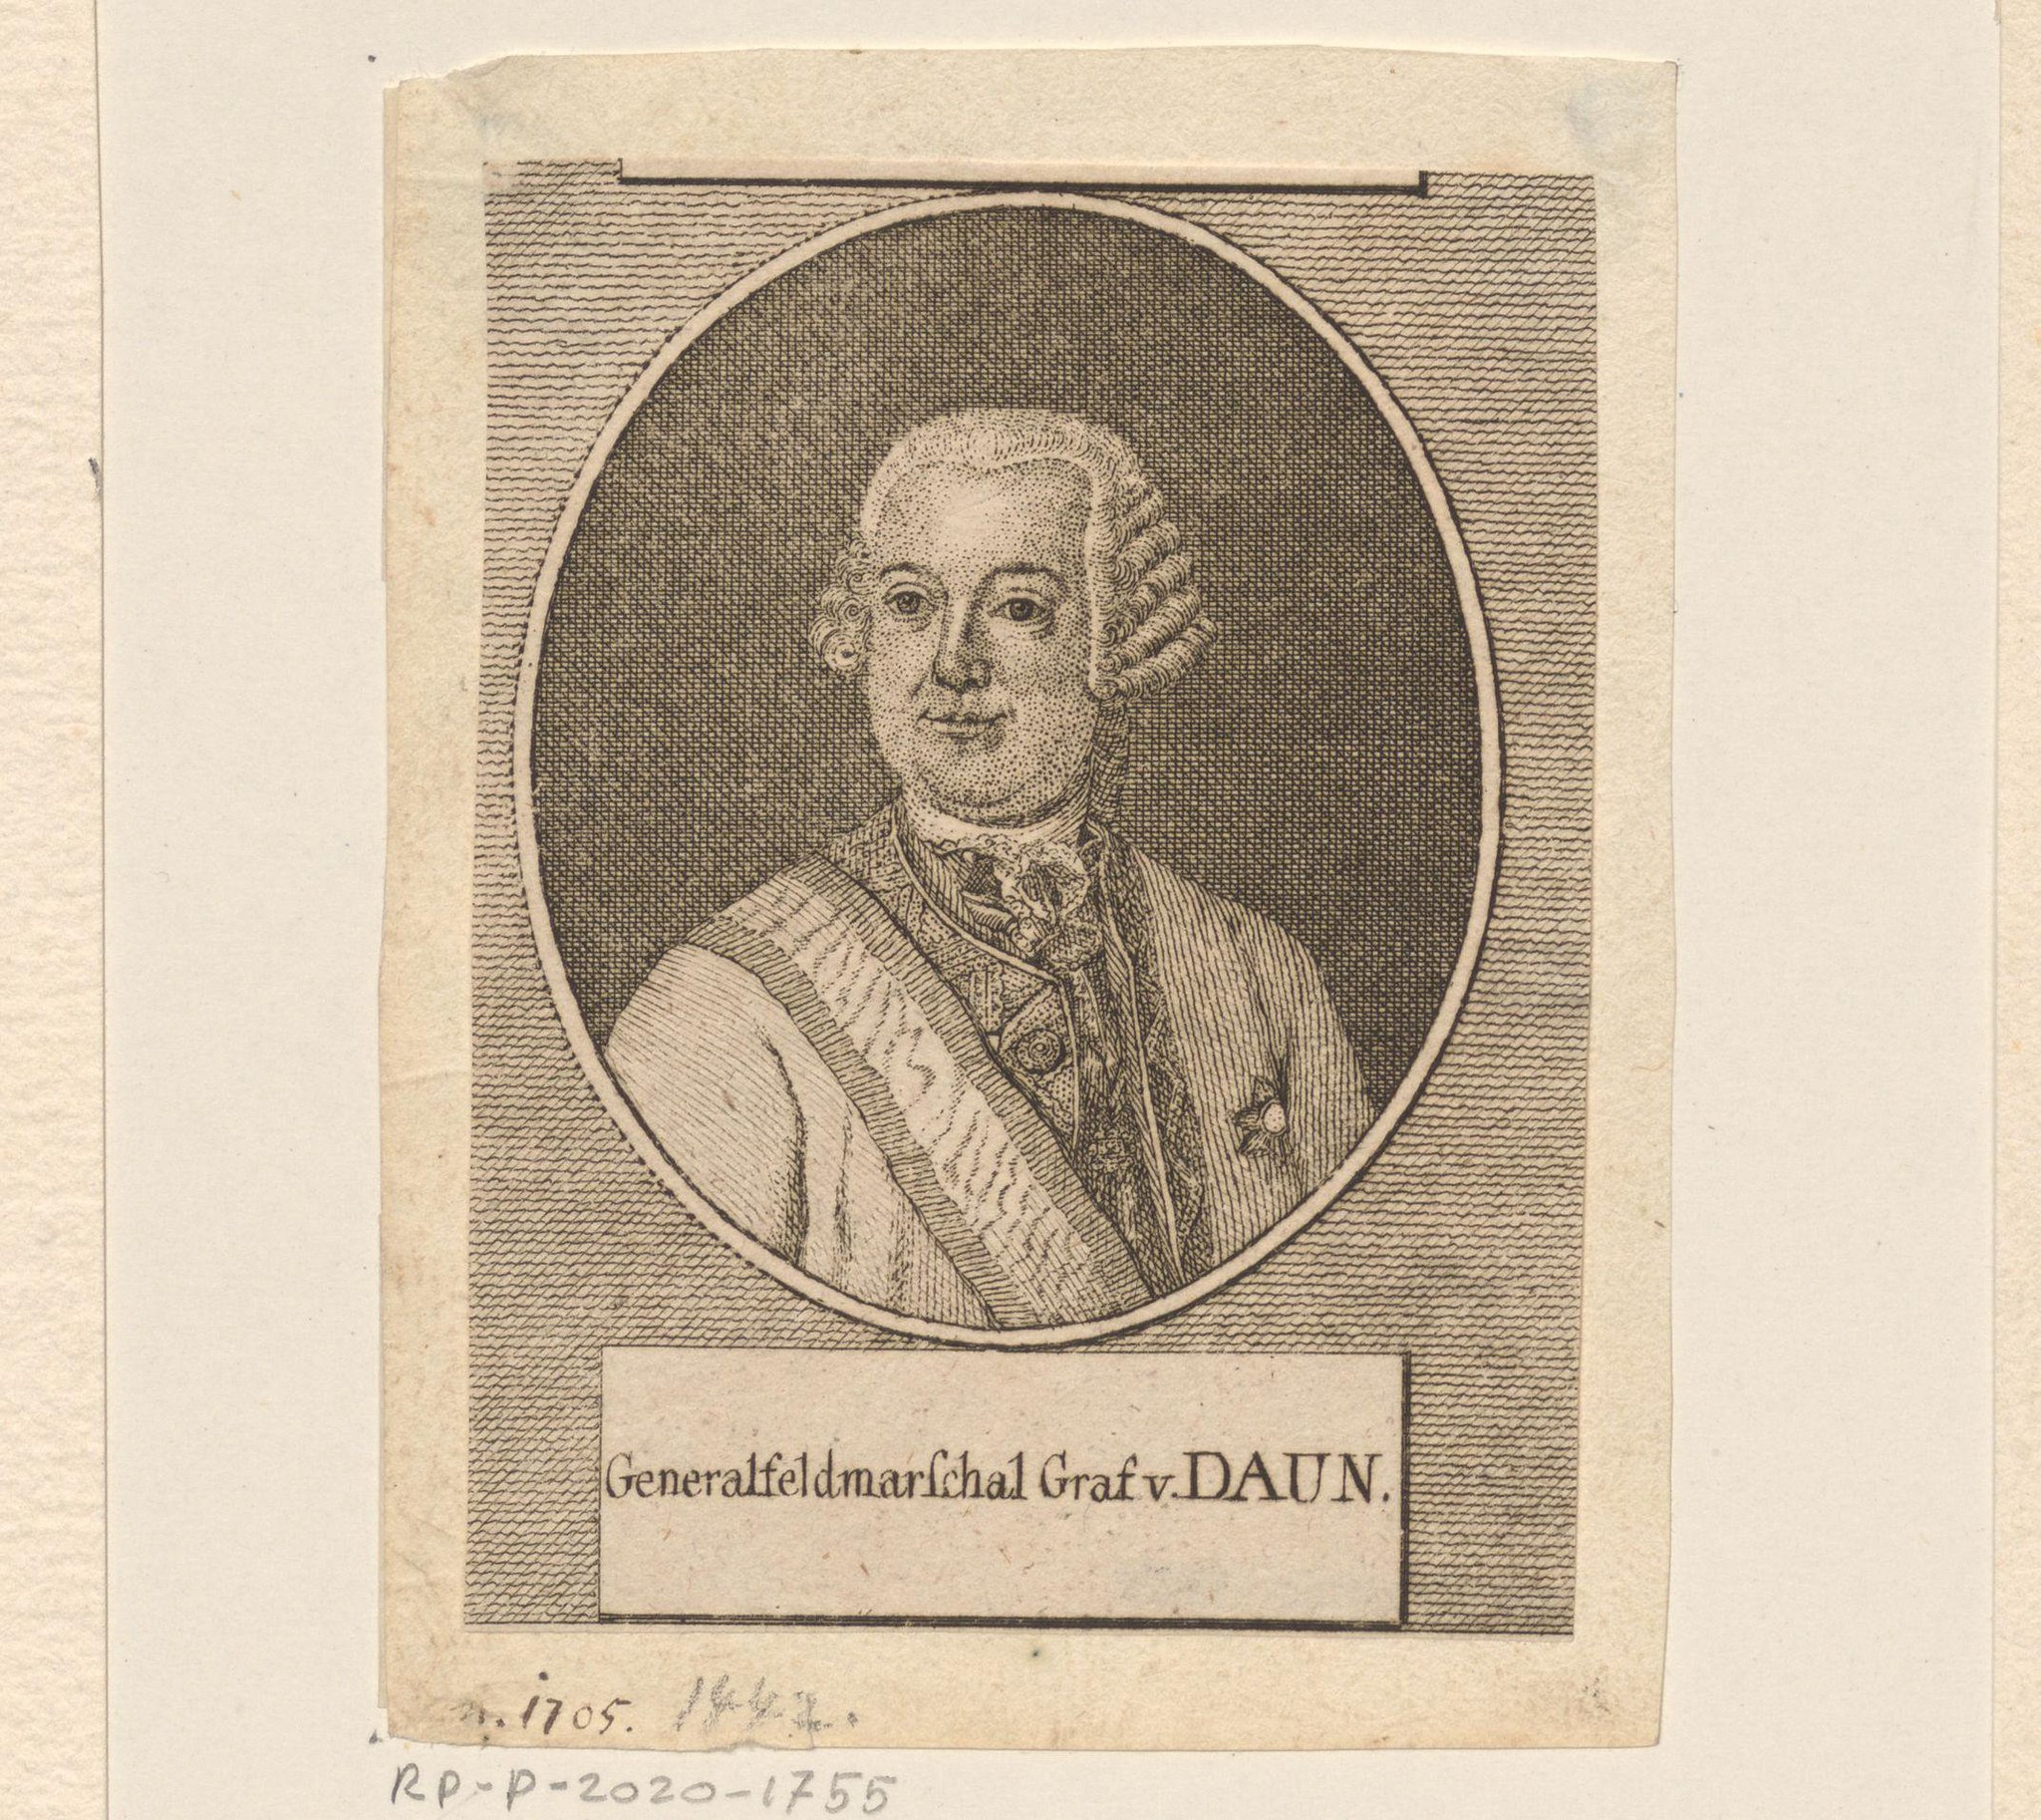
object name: print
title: Portret van Leopold Joseph von Daun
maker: Anonymous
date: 1754-1799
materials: paper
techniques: engraving, etching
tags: commander-in-chief, general, marshal, historical persons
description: Prent heeft mogelijk deel uitgemaakt van een grotere prent die versneden is.